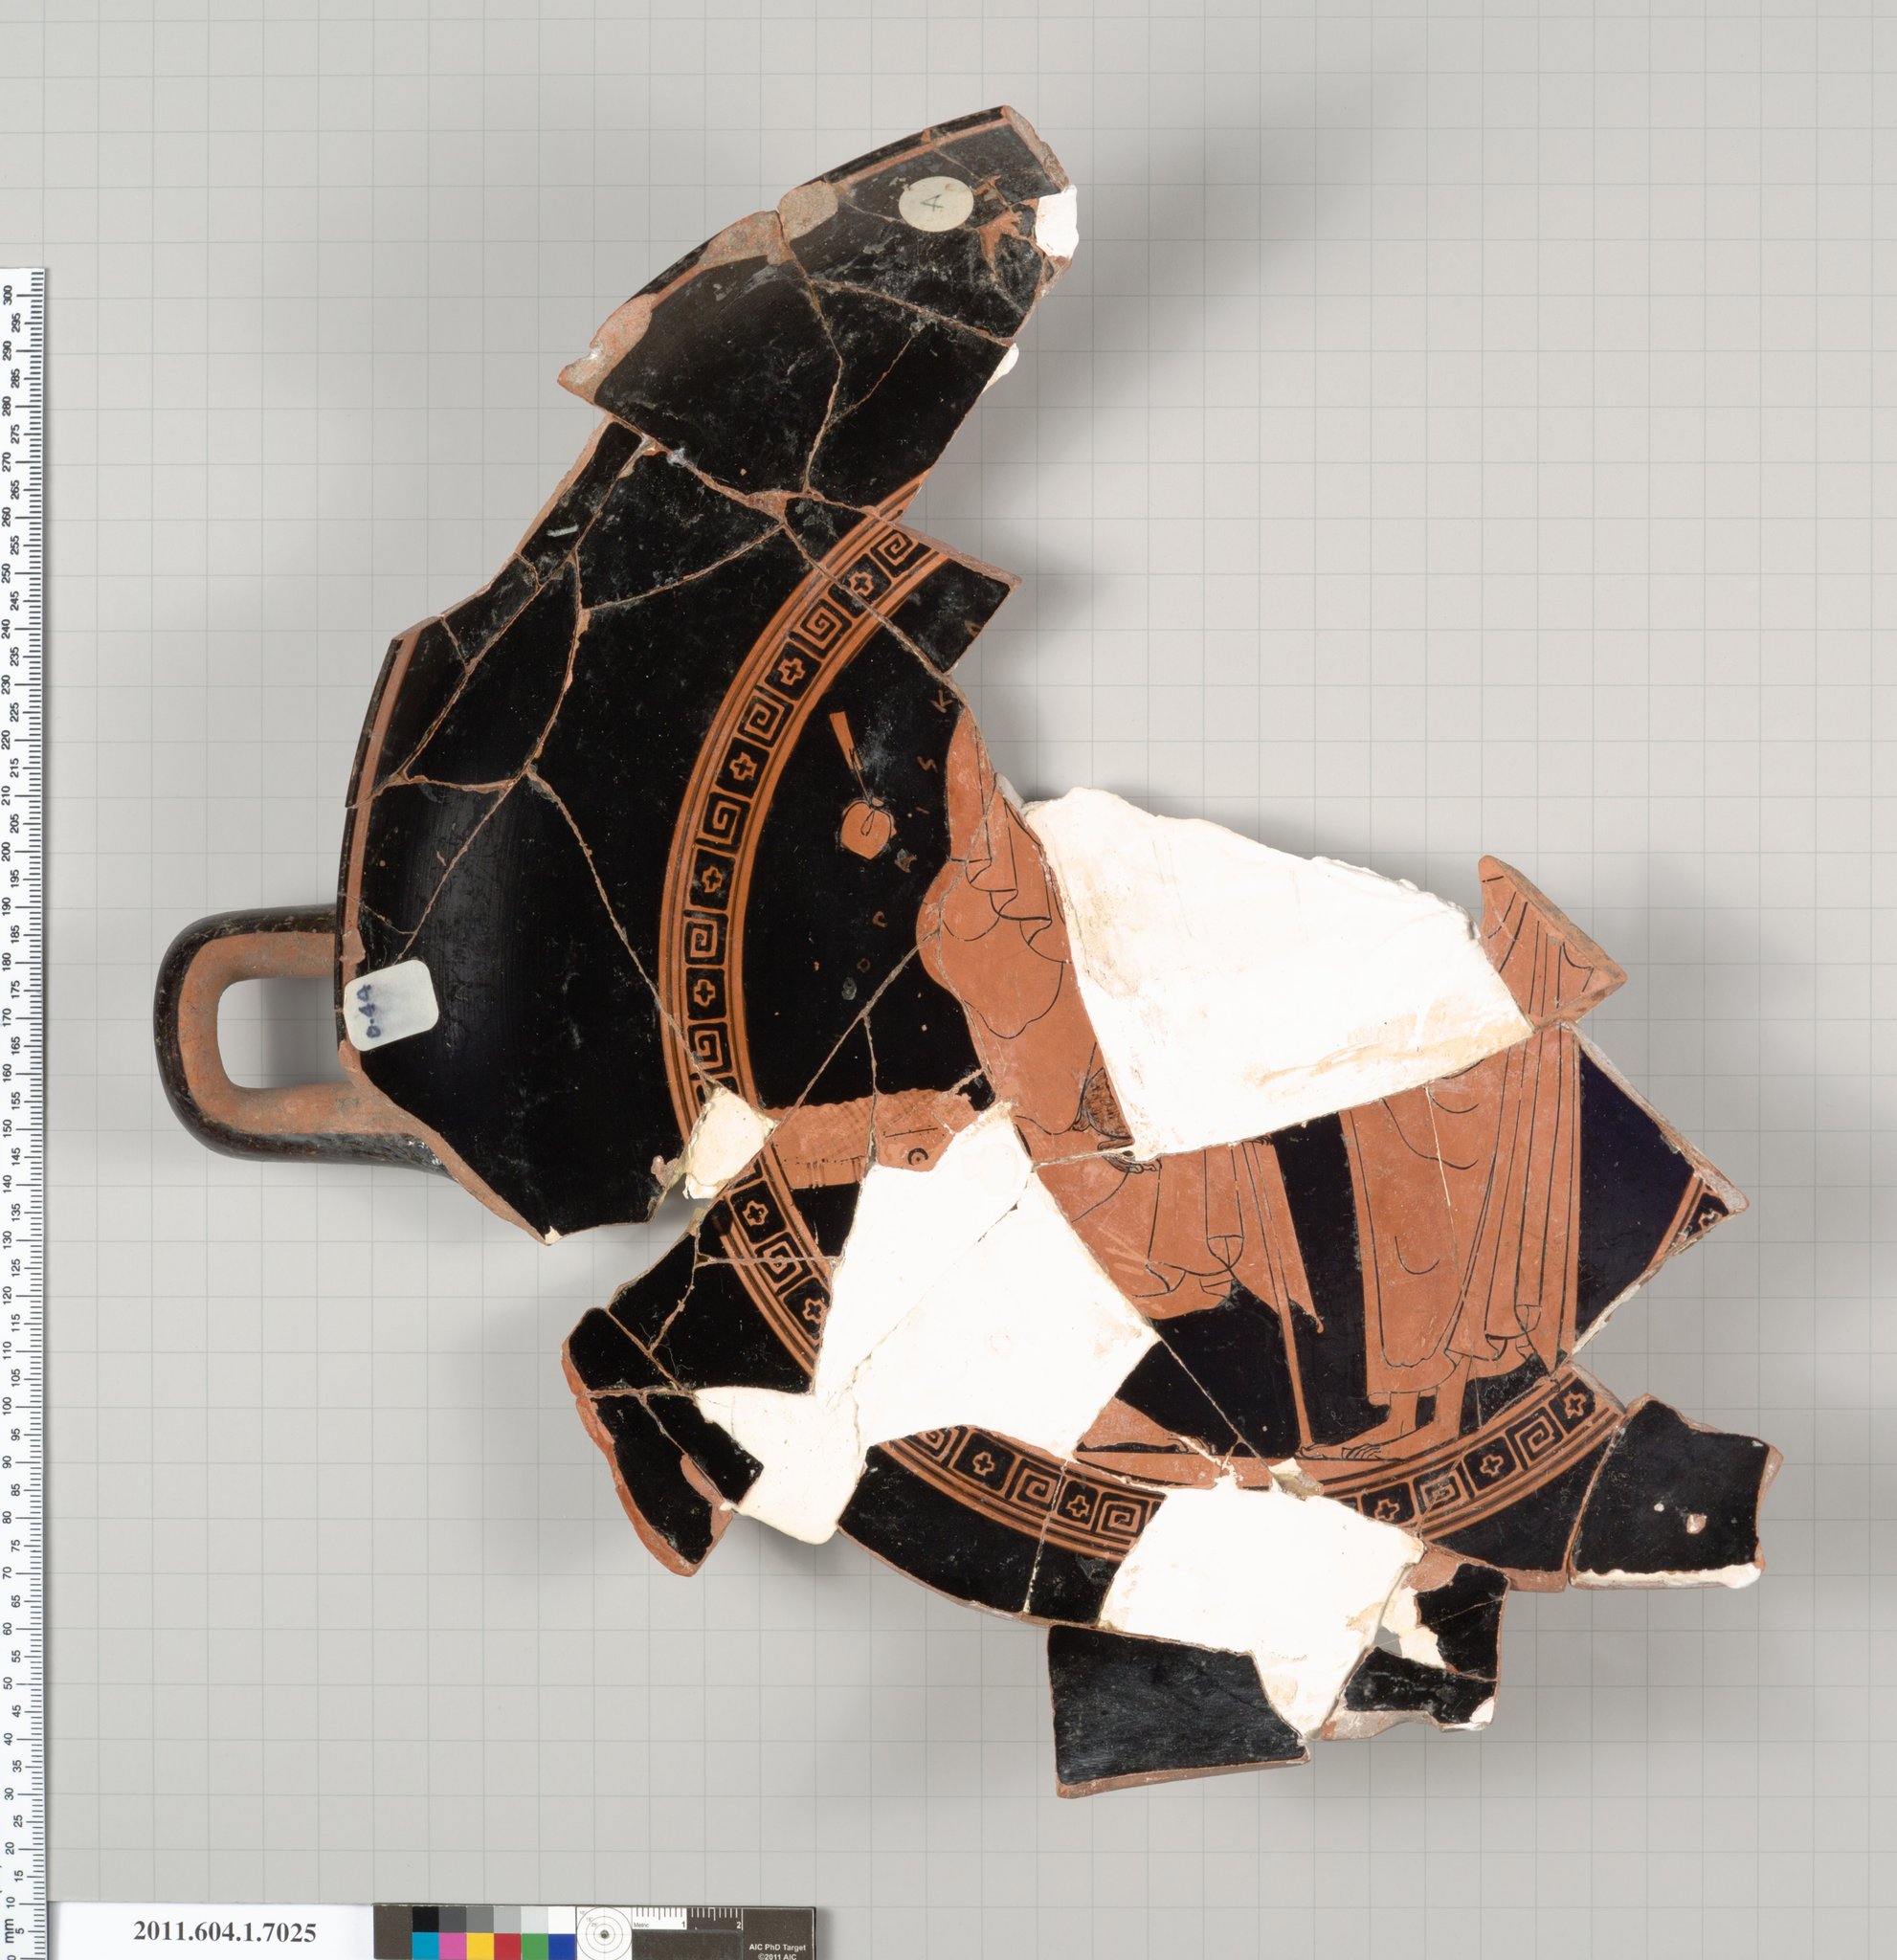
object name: kylix fragment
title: Terracotta fragment of a kylix (drinking cup)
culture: greek, attic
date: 500-480 BCE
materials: terracotta